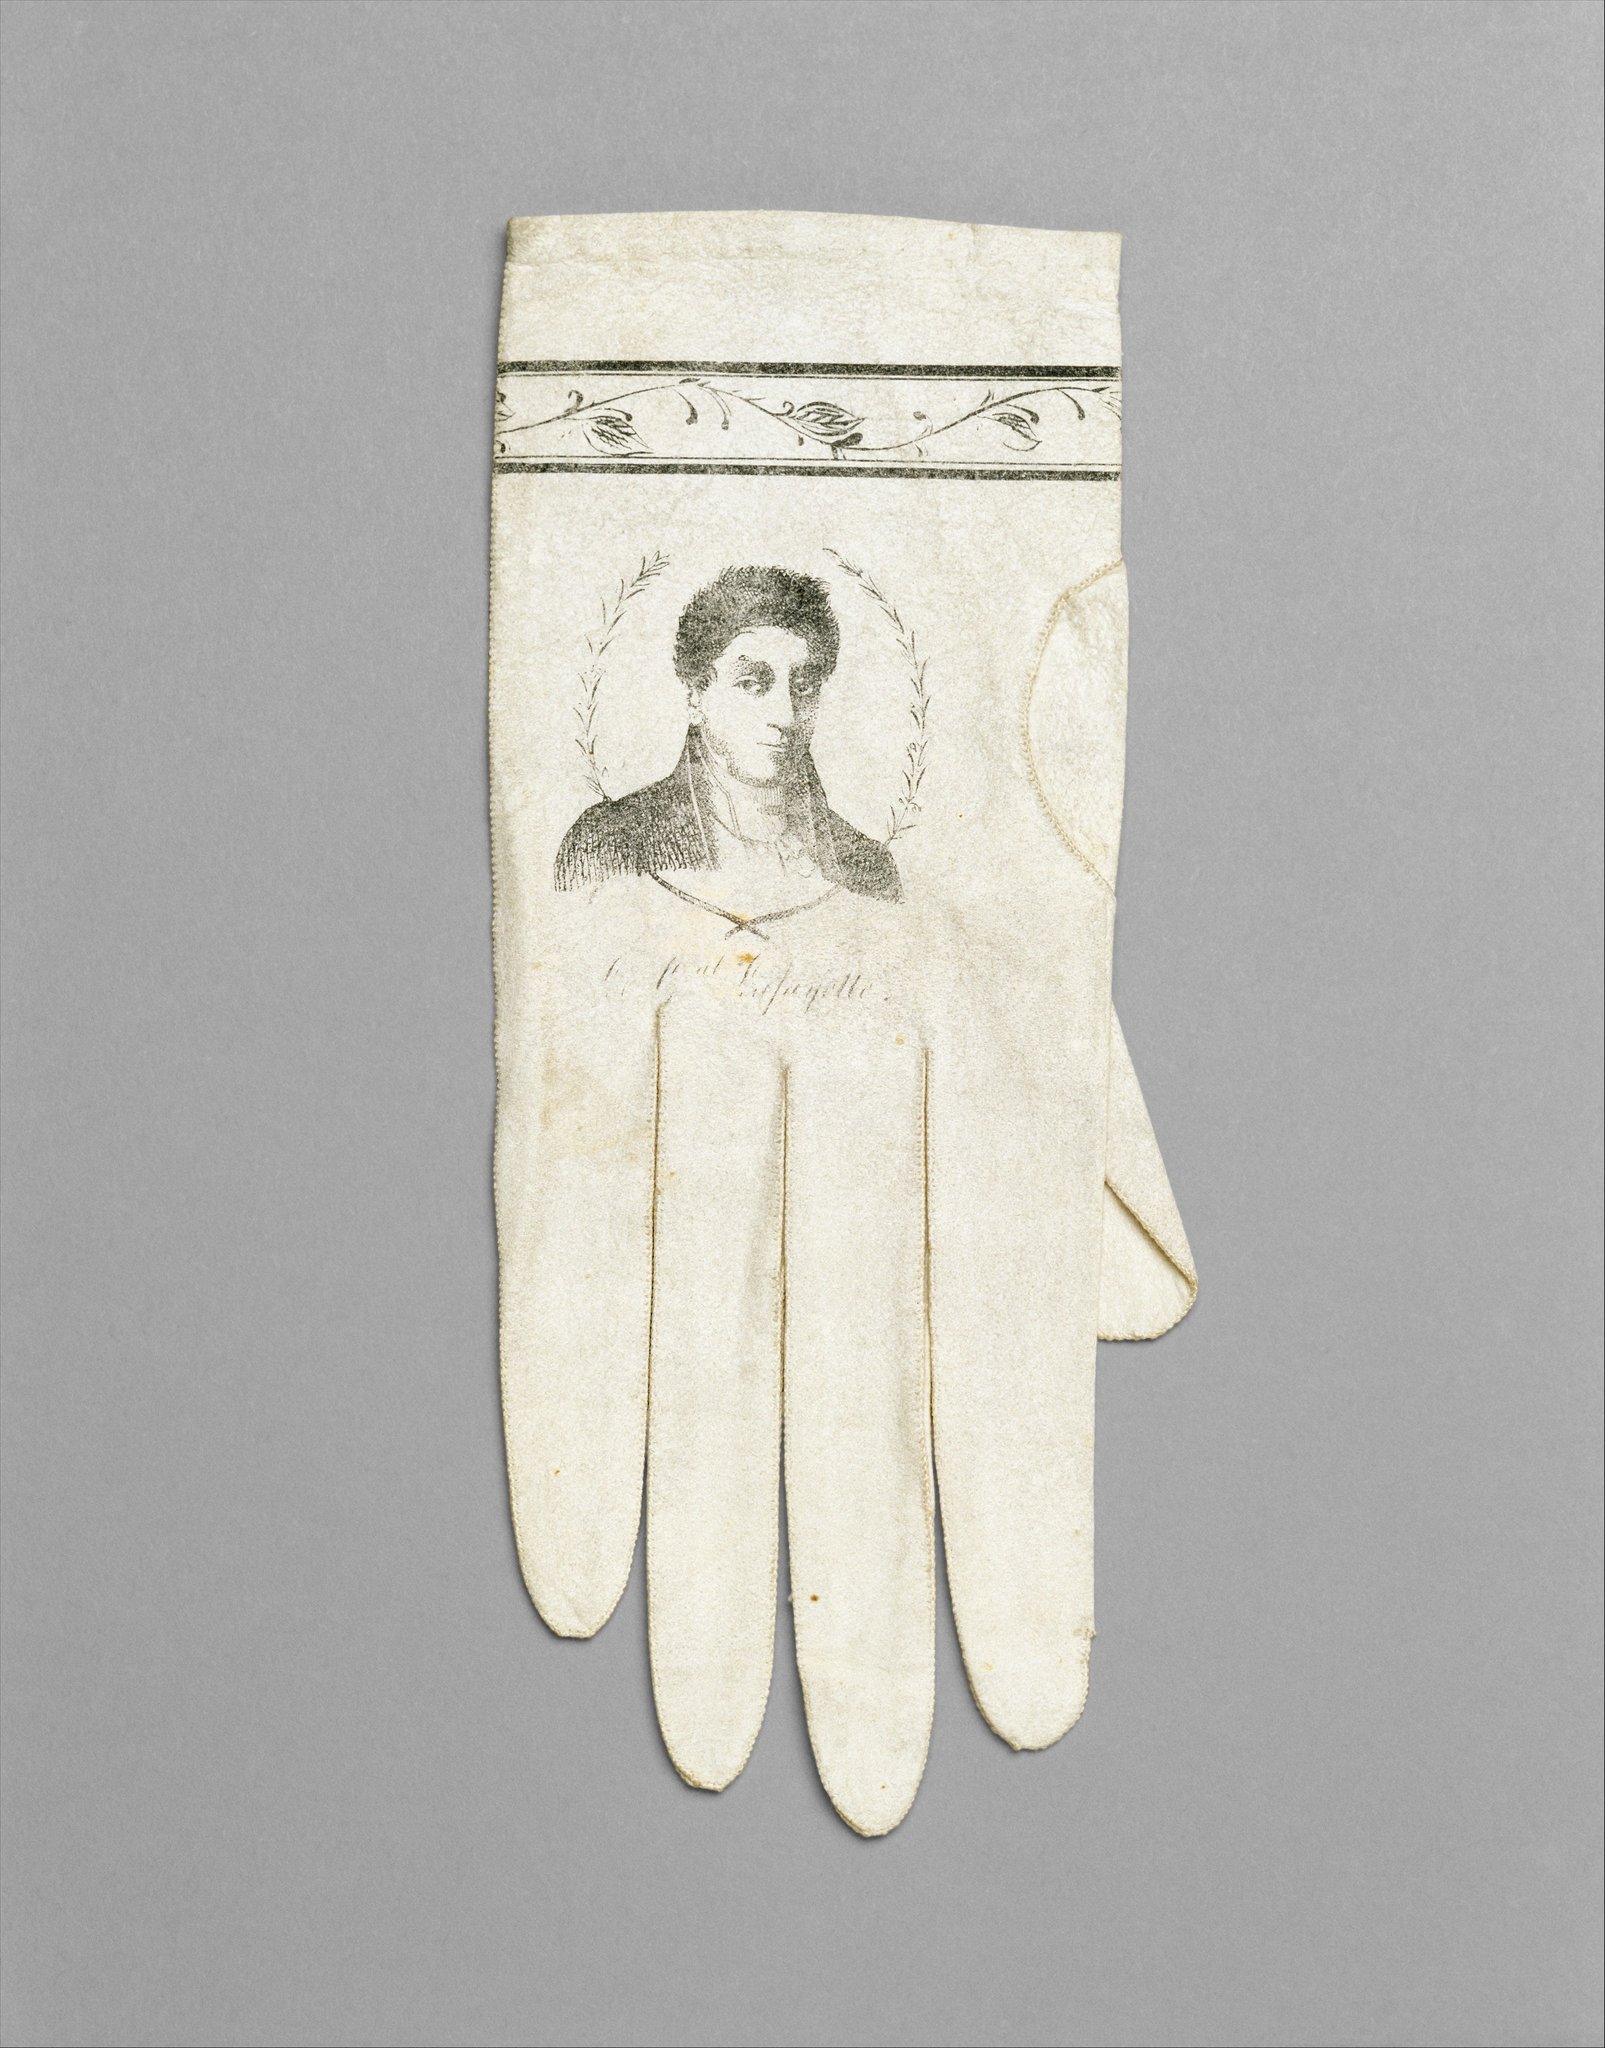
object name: glove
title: Gloves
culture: french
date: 1824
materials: leather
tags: men,portraits